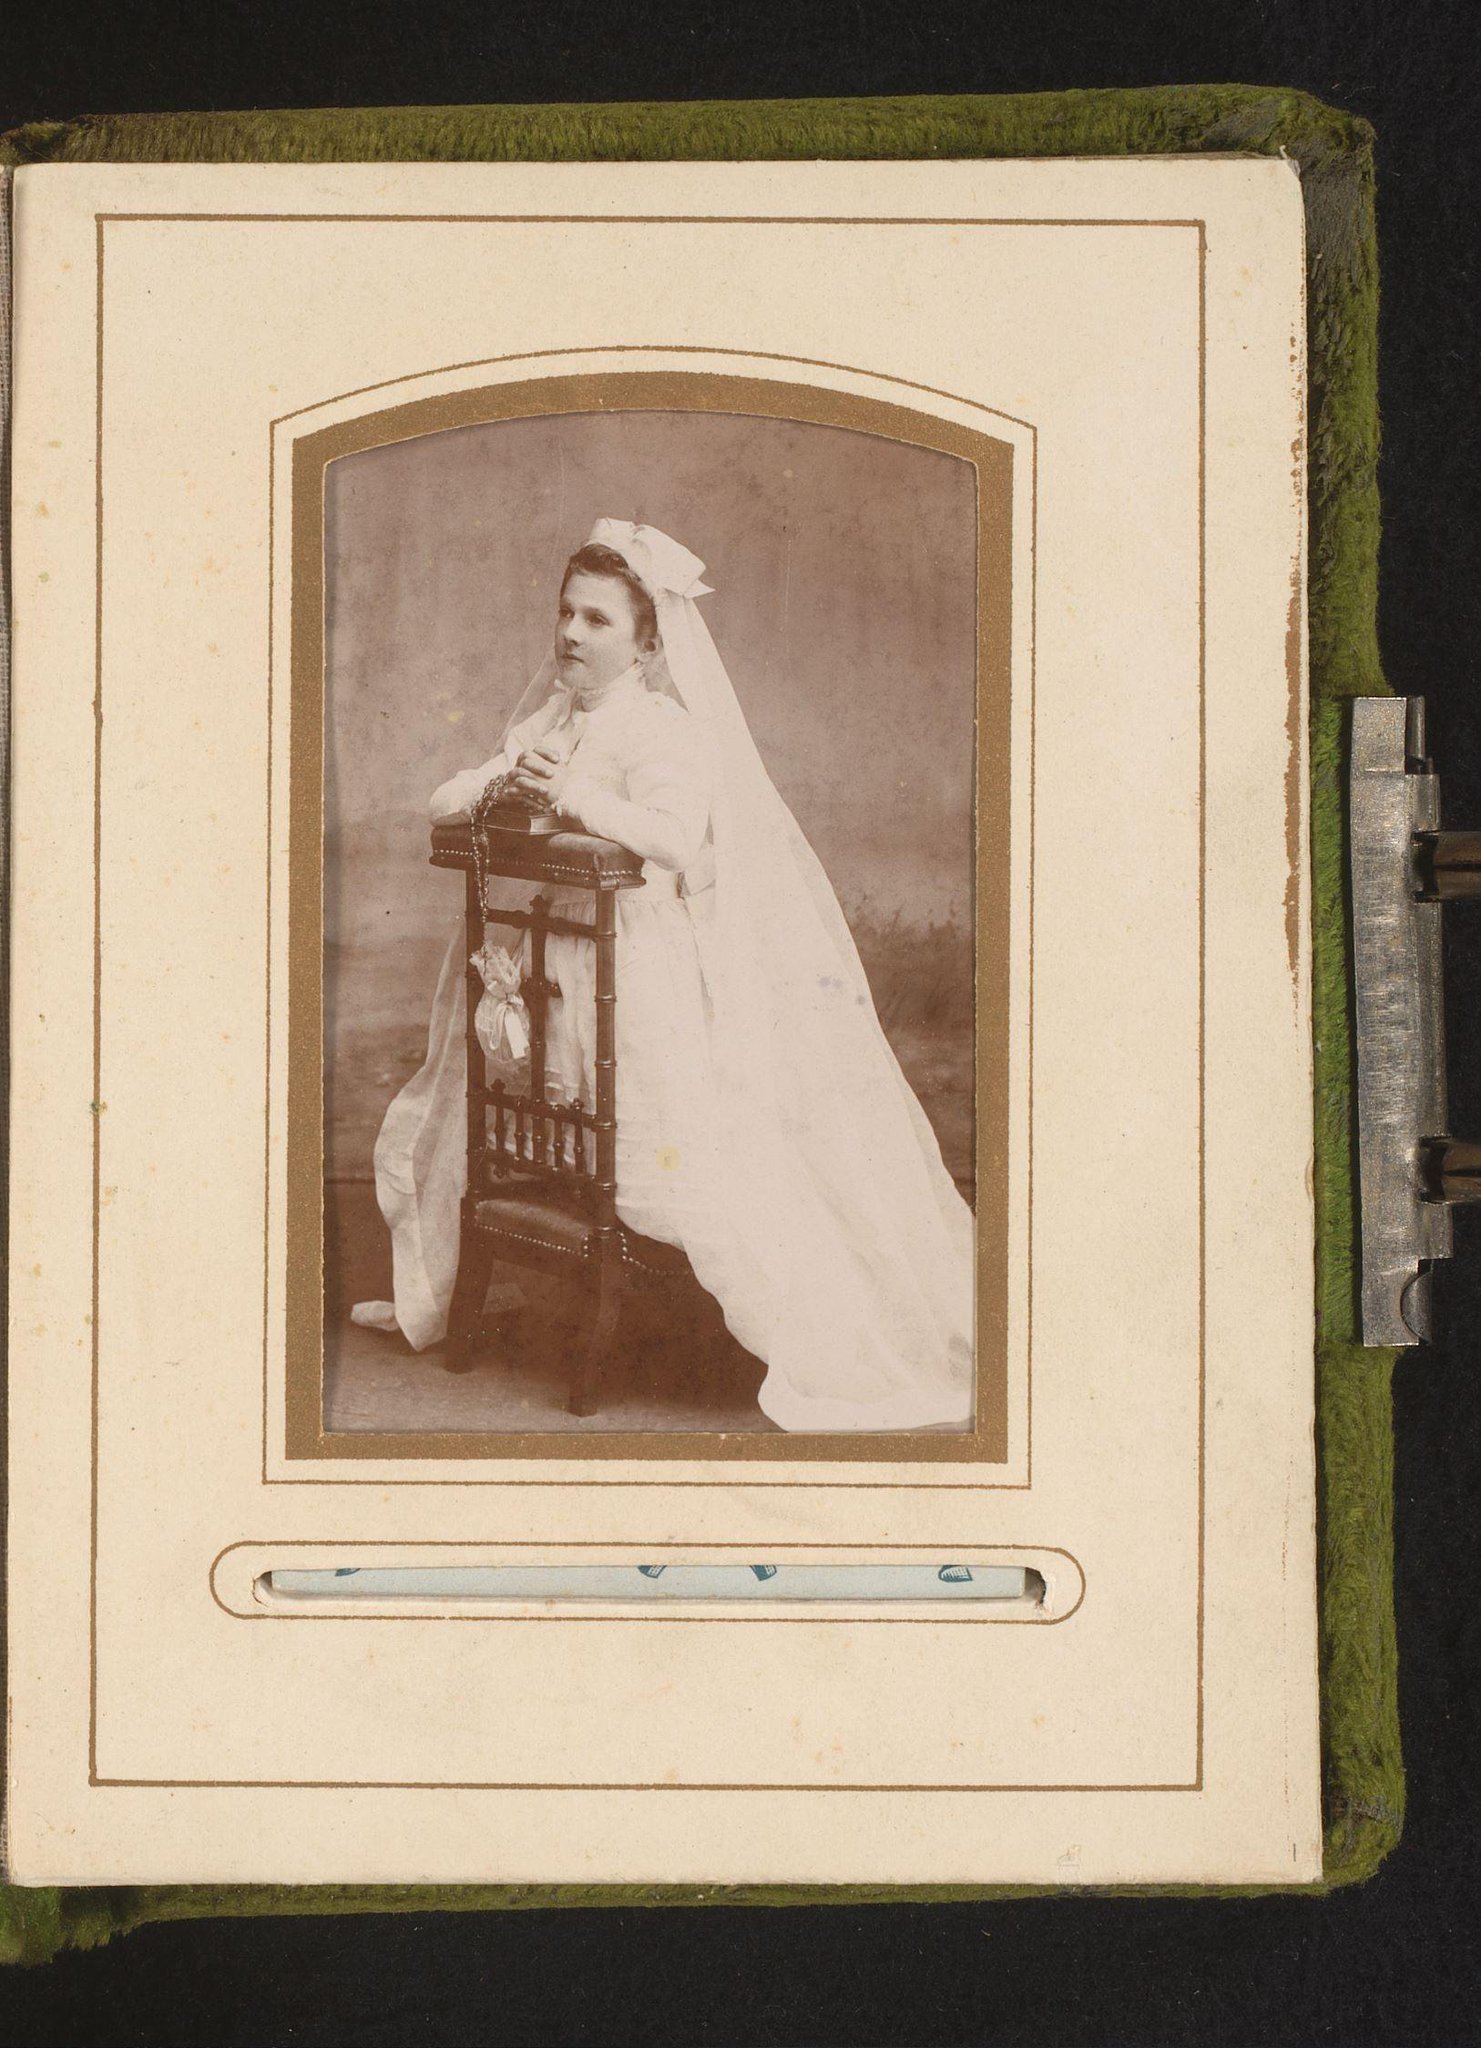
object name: album leaf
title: Portret van een jonge vrouw in een communiejurk op een bidstoel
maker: gilbert micot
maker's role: fotograaf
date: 1860-1900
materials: cardboard, photographic support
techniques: collodion silver print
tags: adolescent, young woman, maiden, communion dress, historical persons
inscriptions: inscription: ‘Photographie/ Gilbert Micot/ Issoire/ Provédé Breveté(...)’